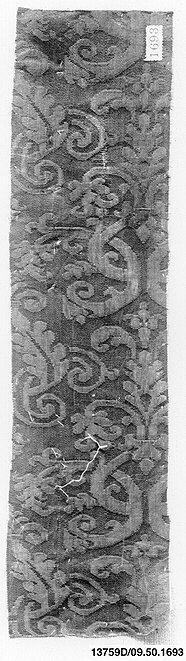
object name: piece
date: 1501-1600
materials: silk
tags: leaves